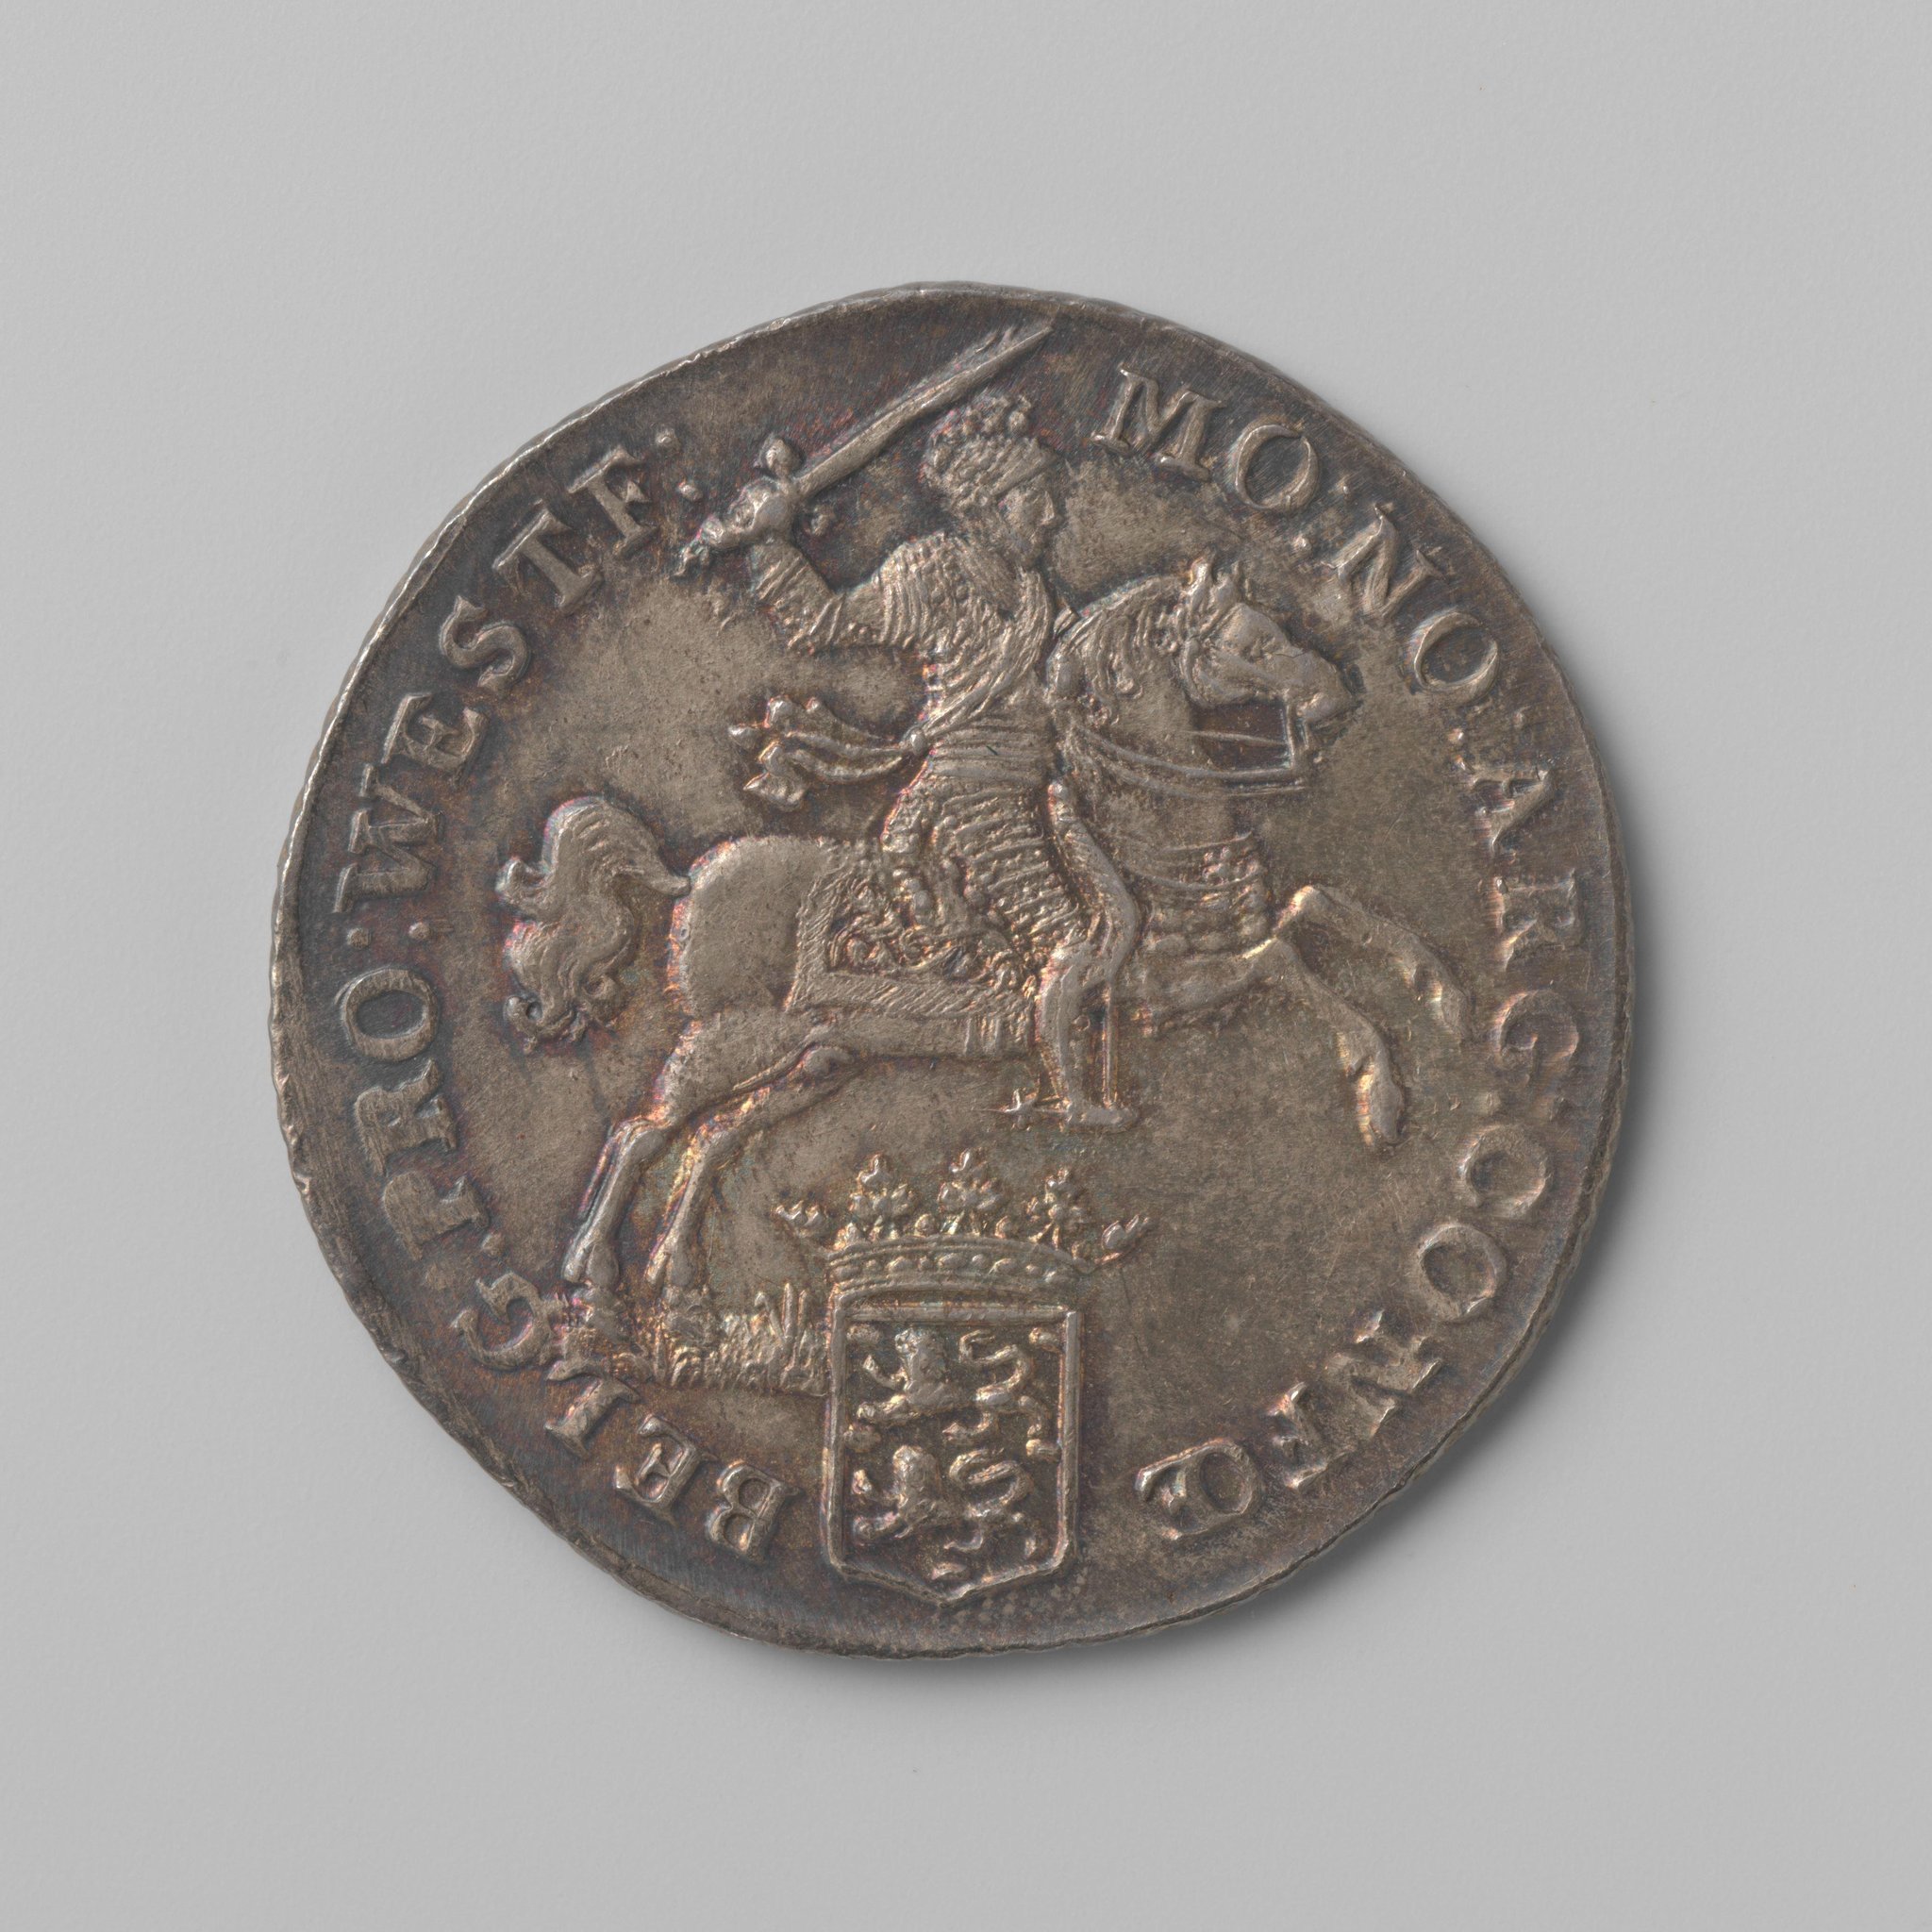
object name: coin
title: Westfriese halve zilveren rijder, 1791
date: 1791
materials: silver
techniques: striking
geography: west frisia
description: Zilveren munt. Voorzijde: boven gekroond wapenschild van West-Friesland ridder met in rechterhand zwaard naar rechts. Keerzijde: door twee leeuwen gehouden gekroond generaliteitswapenschild. In cartouche onder kroon jaartal. Kabelrand.